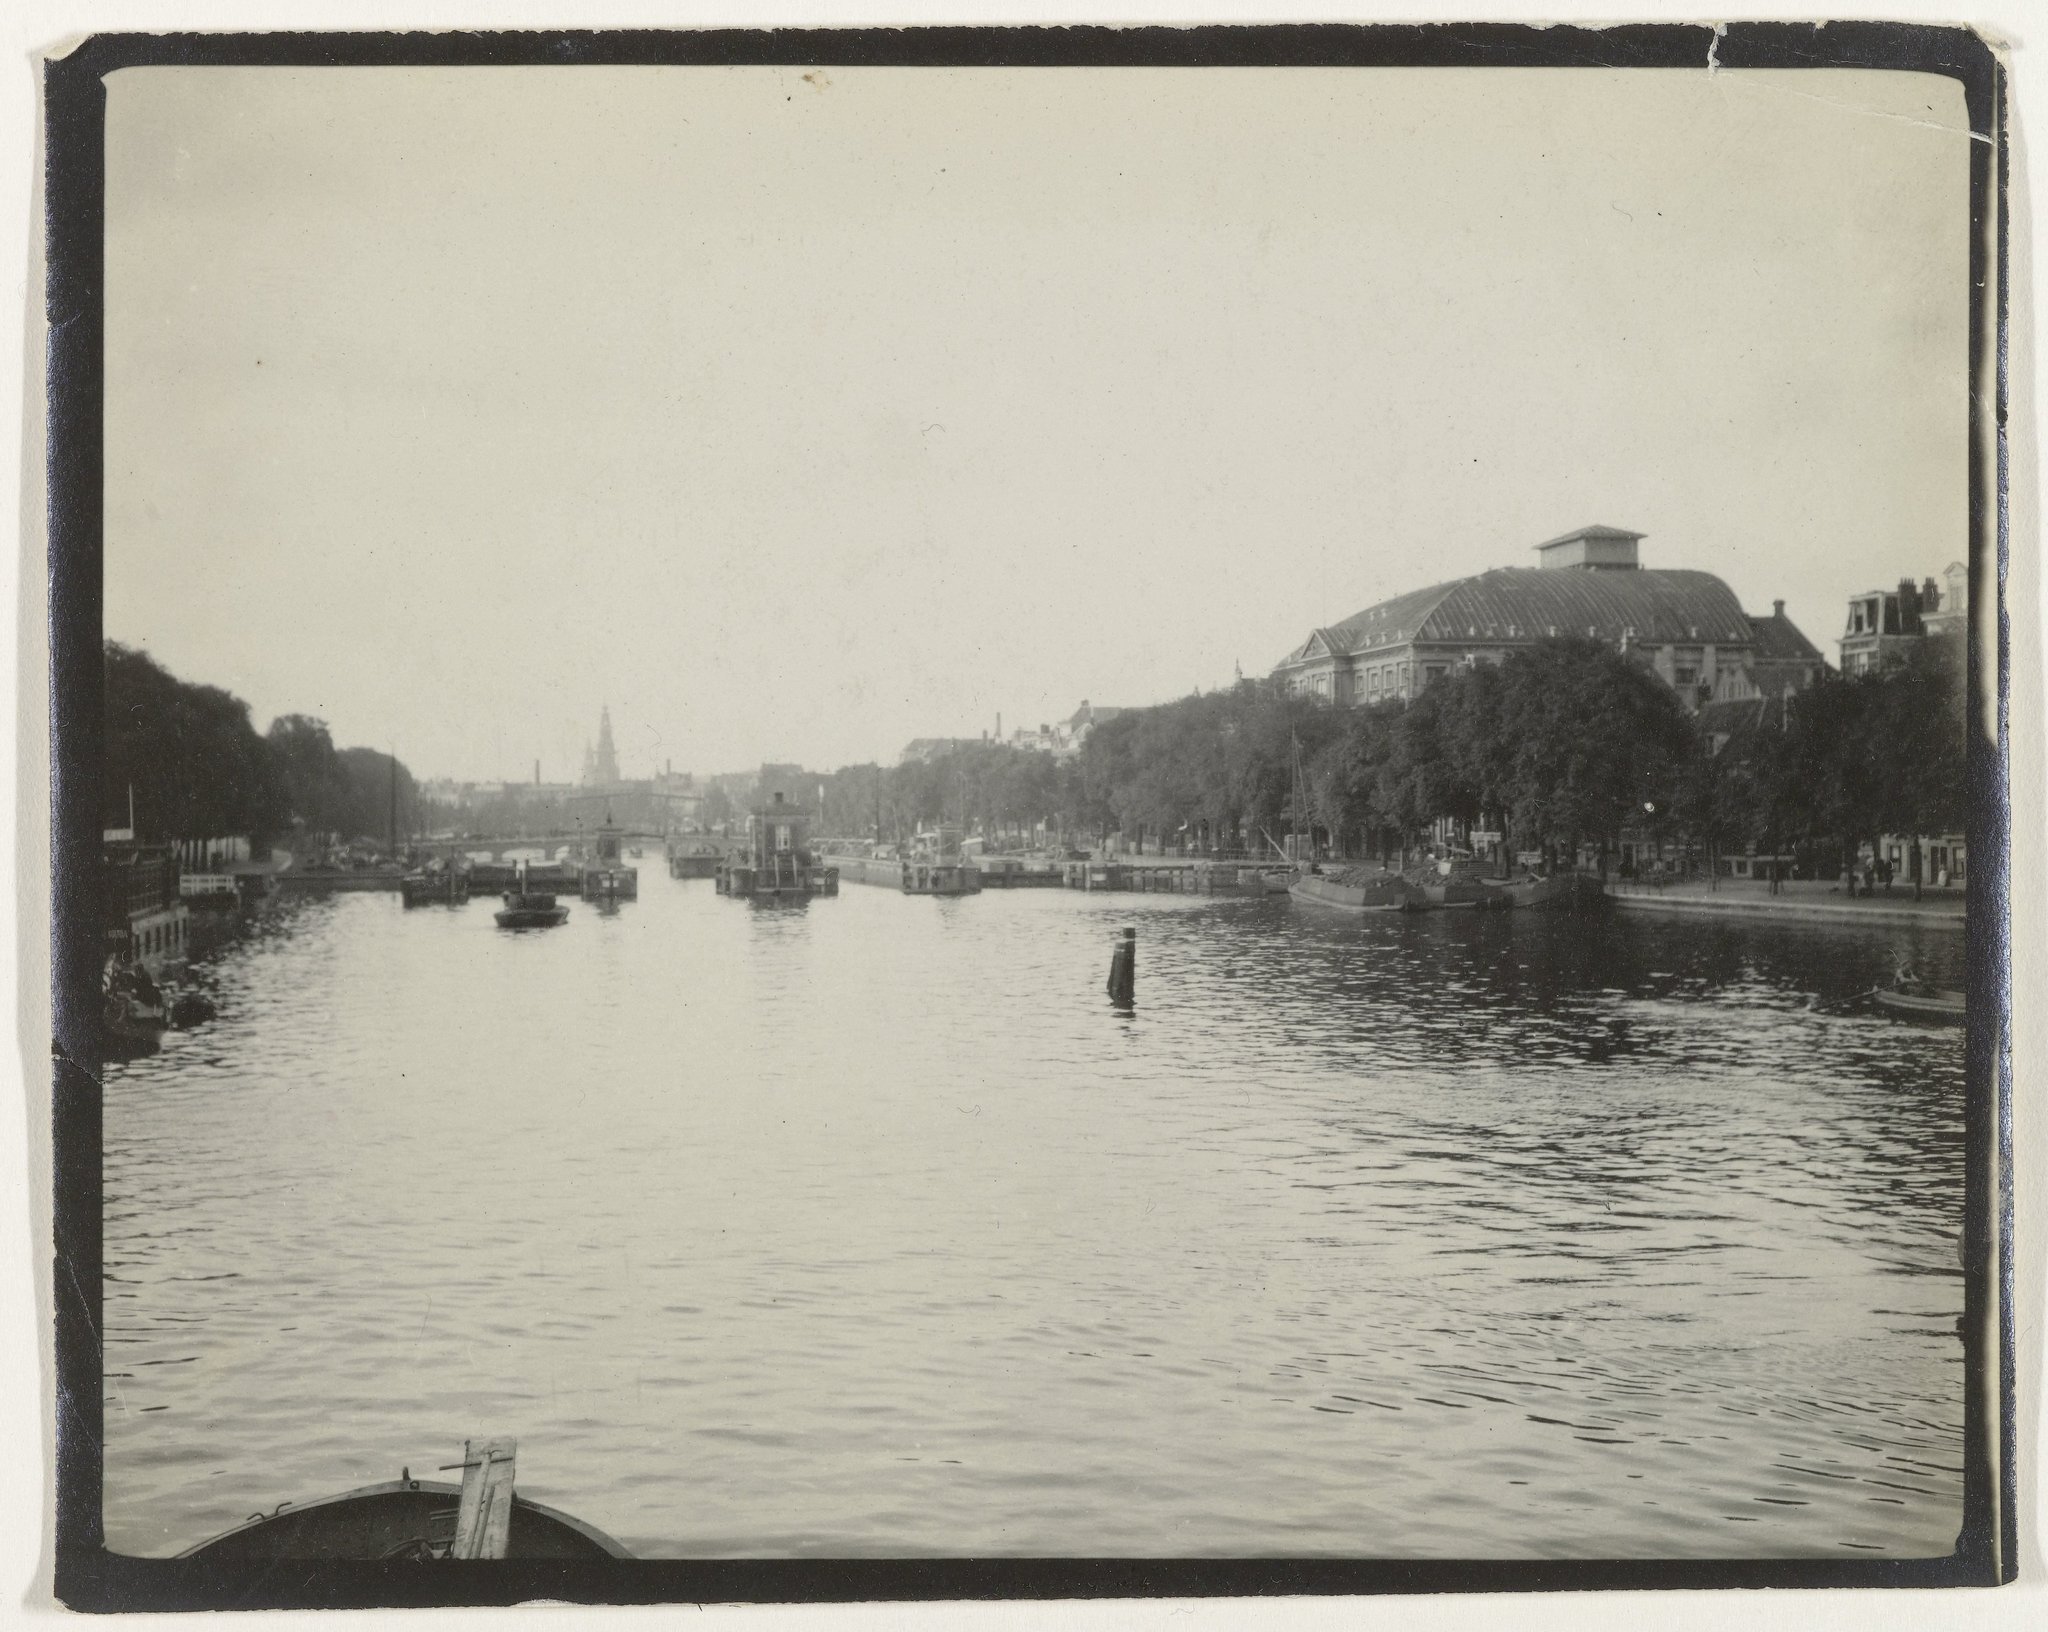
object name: photograph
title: Gezicht over de Amstel, Amsterdam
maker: Anonymous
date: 1900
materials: photographic support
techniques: gelatin silver print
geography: amsterdam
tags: canals, waters (in city)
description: Gezicht over de Amstel, Amsterdam, met rechts Carré en in het midden de Amstelsluizen.